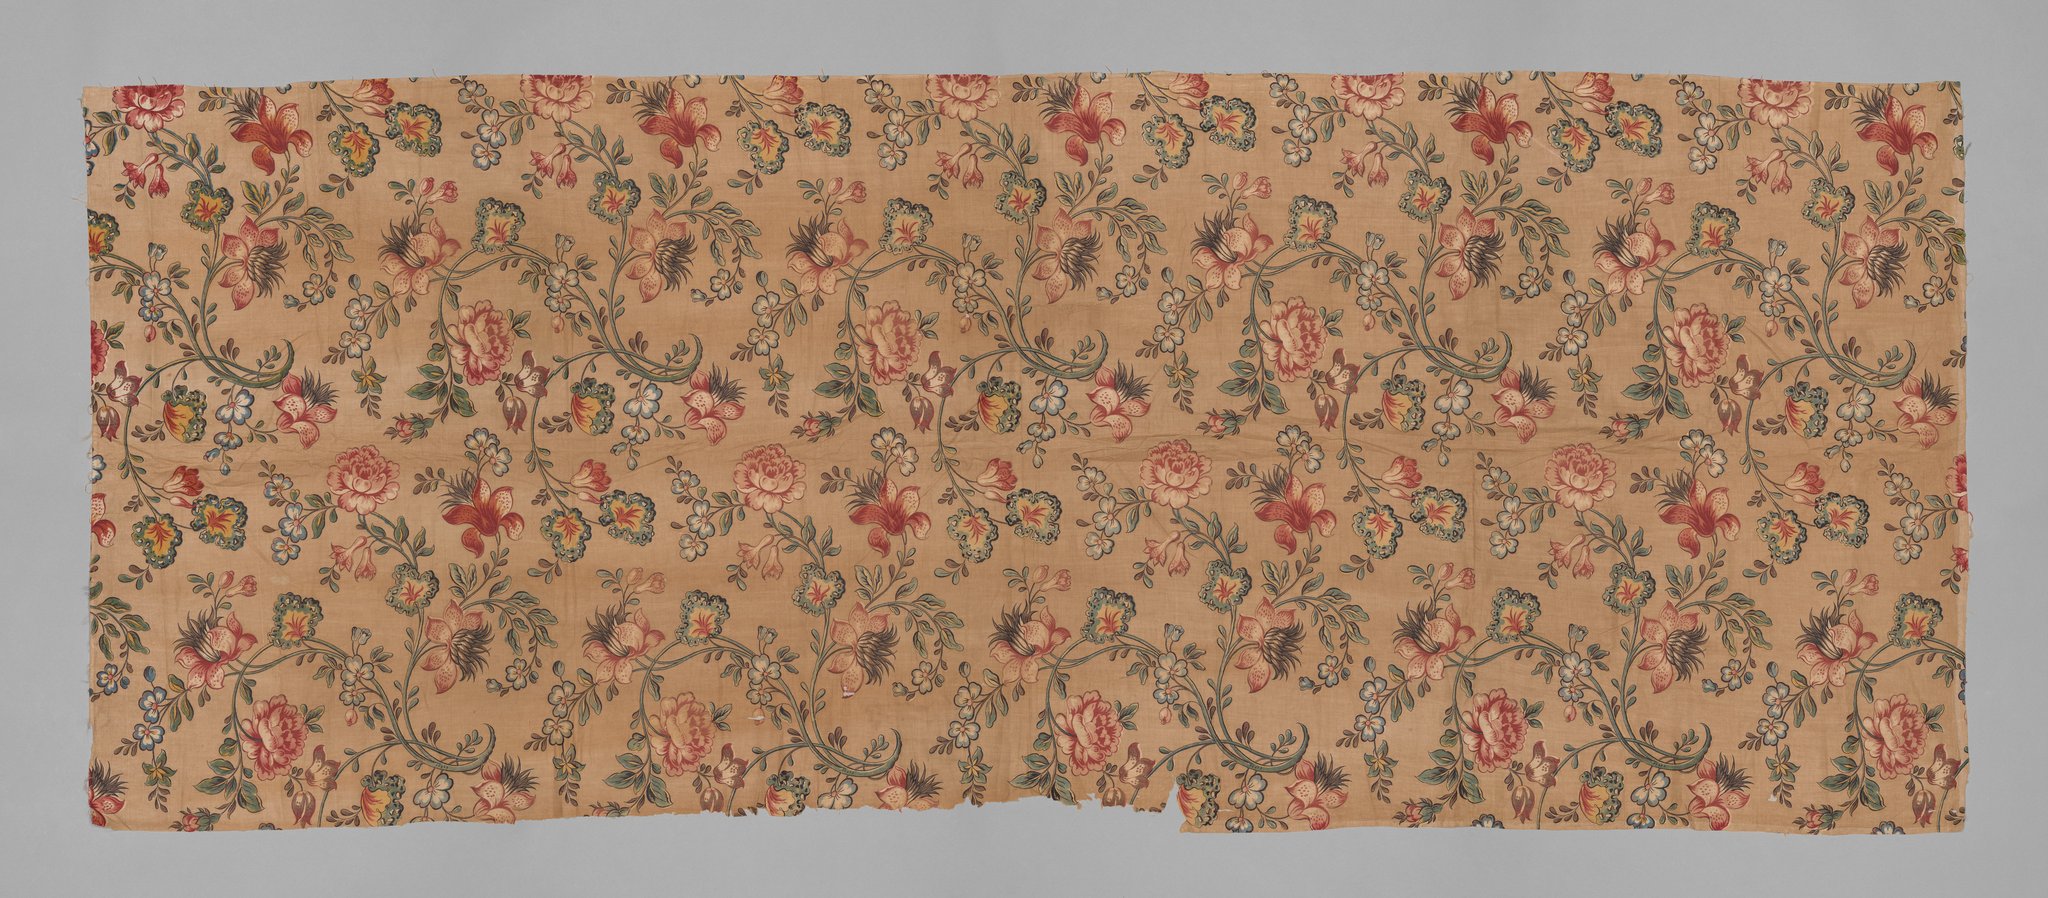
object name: length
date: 1790-1799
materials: cotton